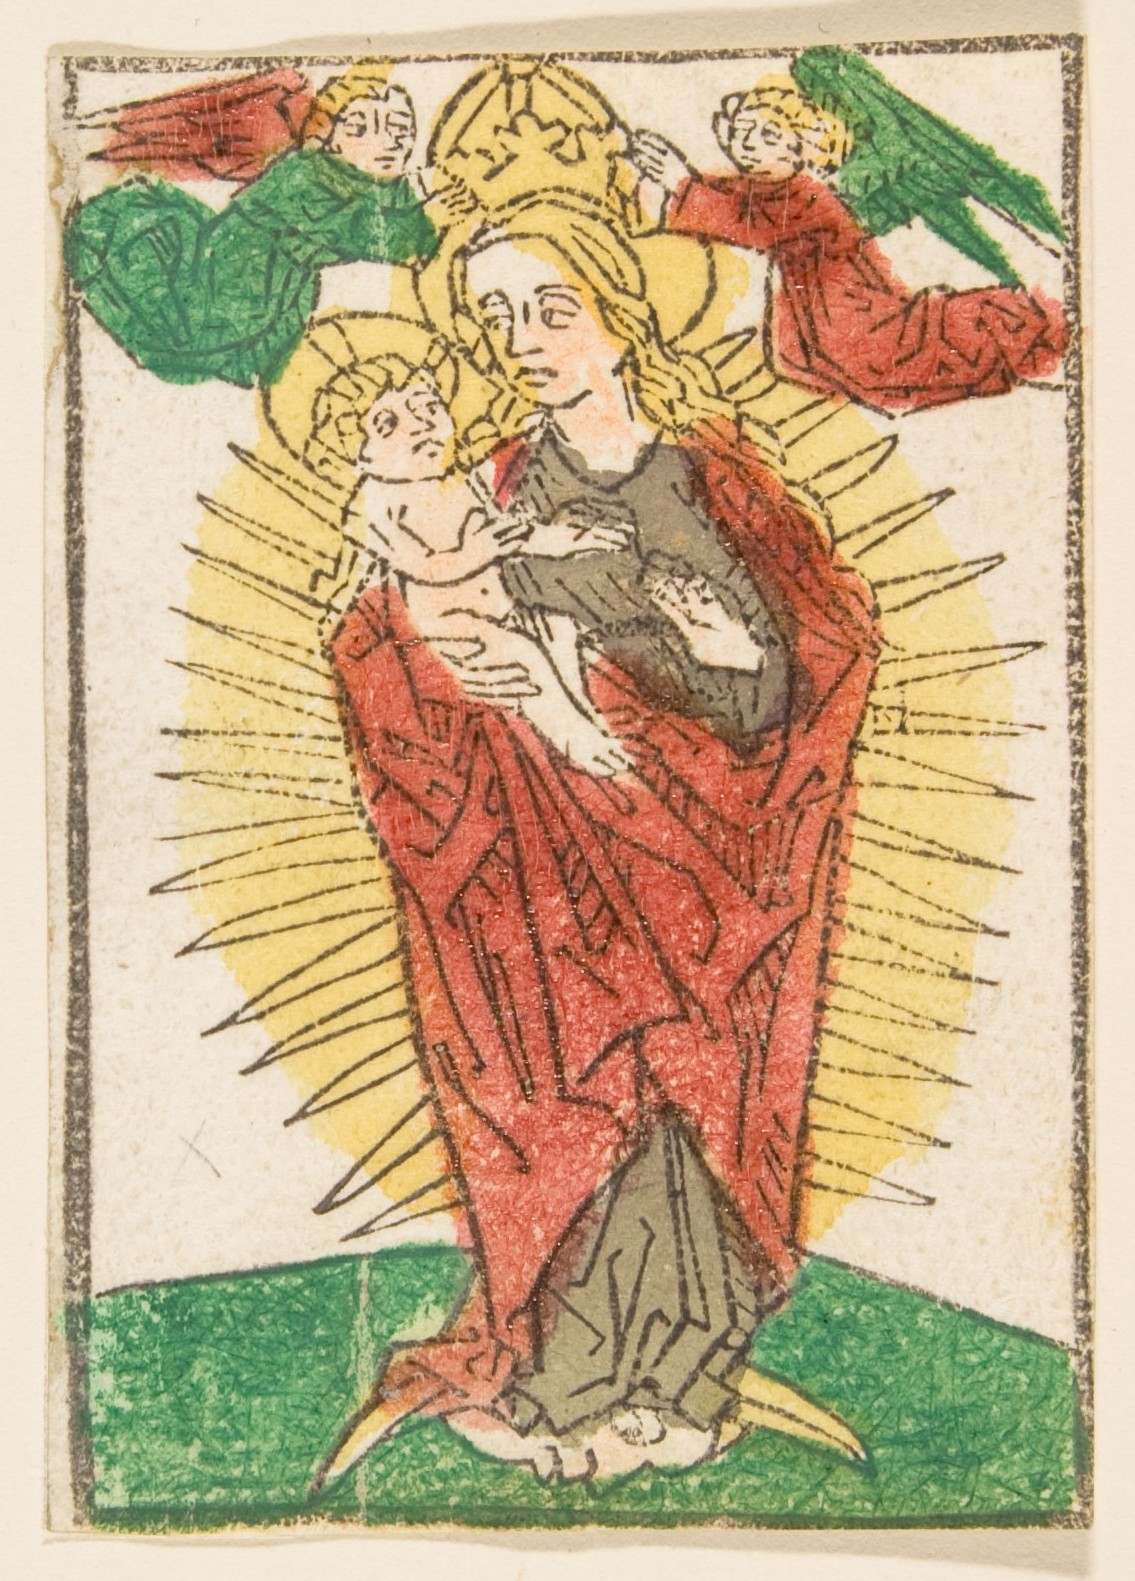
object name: print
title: Madonna in Glory Crowned by Angels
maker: anonymous, german, 15th century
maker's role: artist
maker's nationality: german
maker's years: 1400-1500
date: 1401-1500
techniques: hand coloring, woodcut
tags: angels,madonna and child